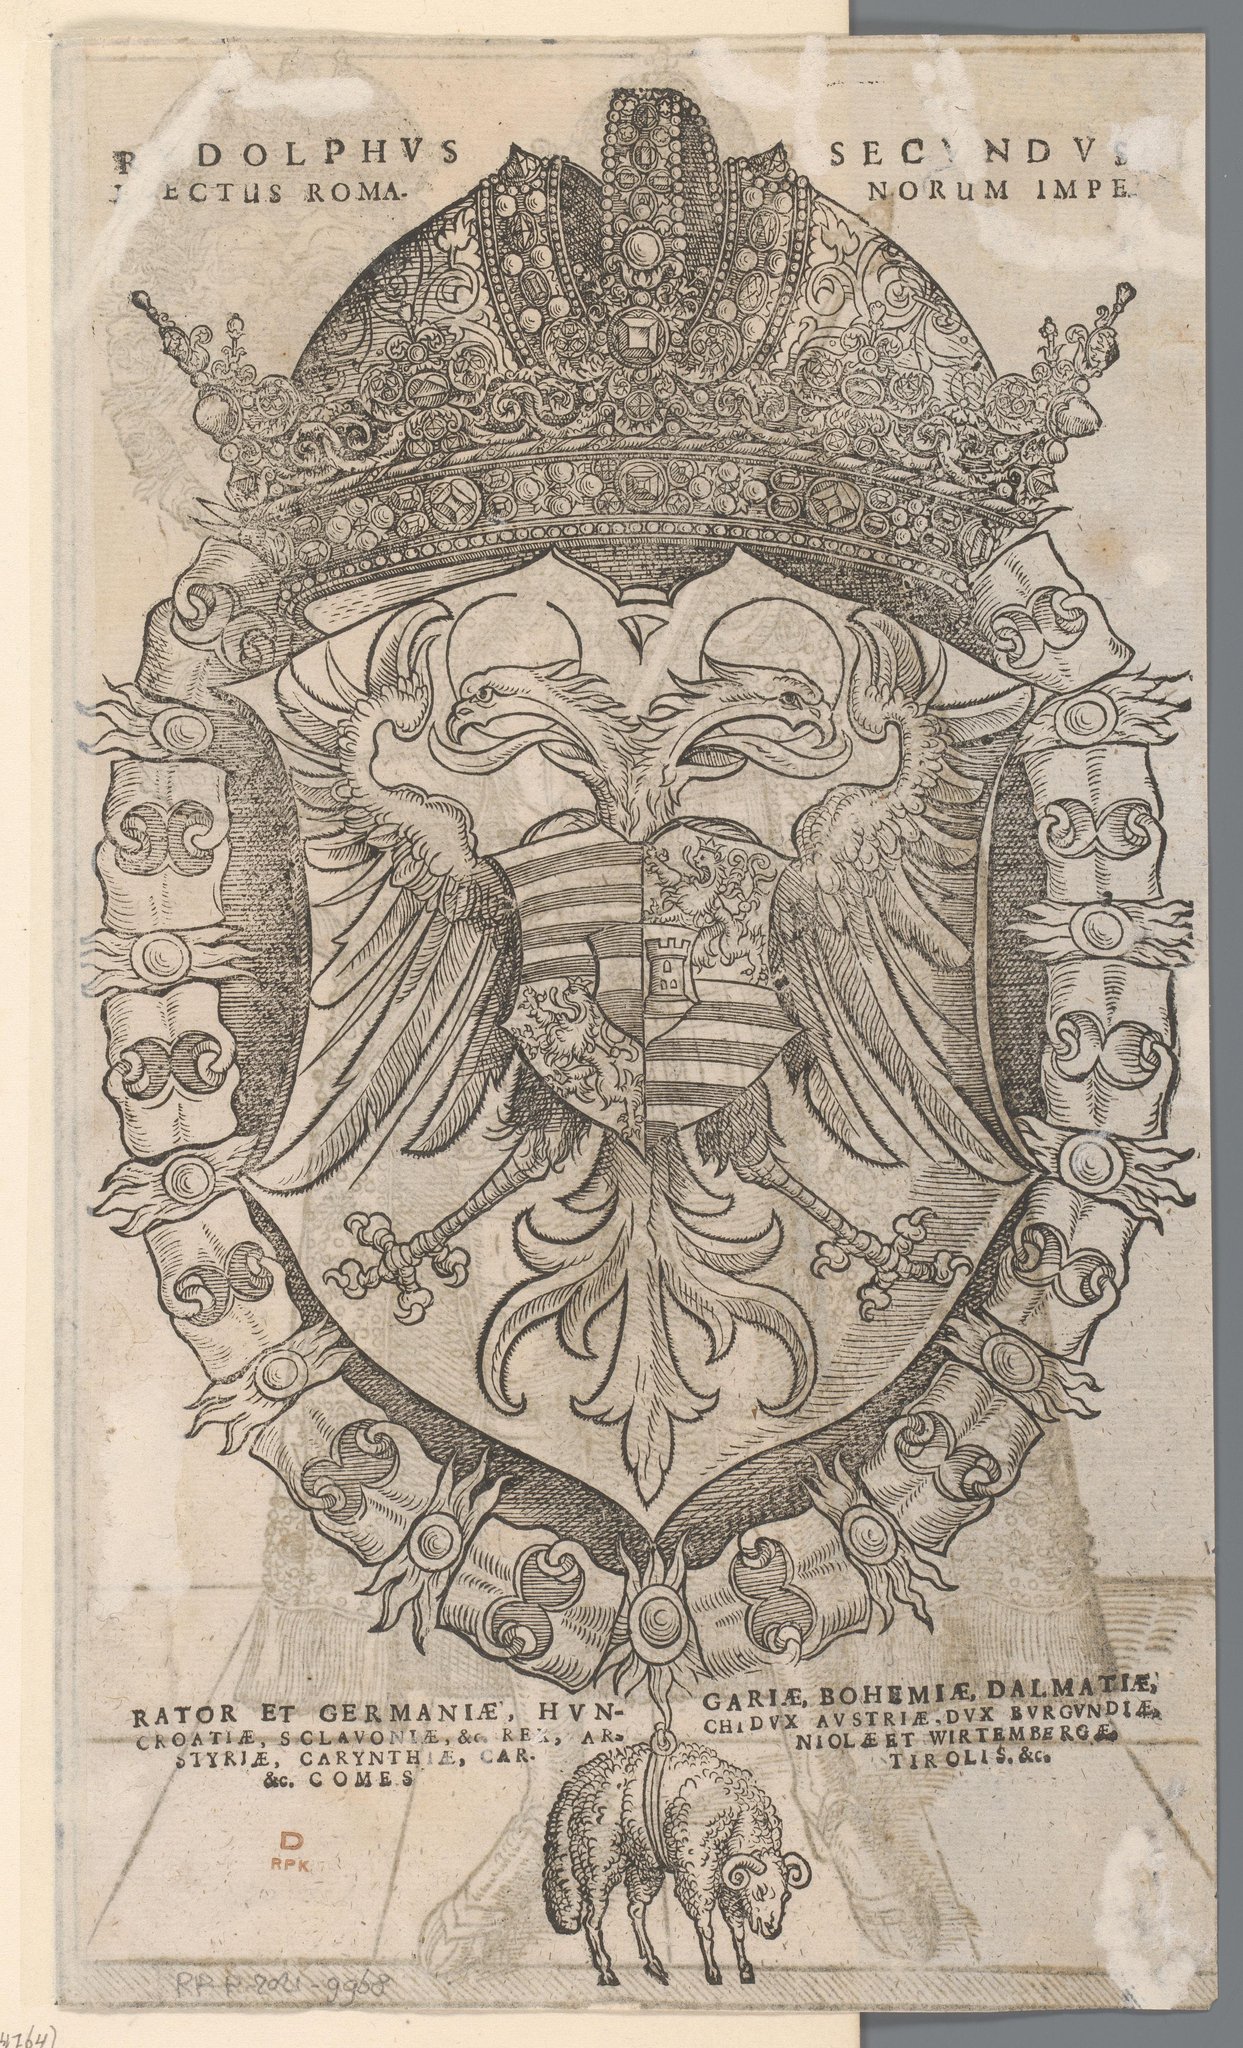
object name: print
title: Wapenschild van Rudolf II van Habsburg, Duits keizer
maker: Anonymous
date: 1576-1649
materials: paper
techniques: woodcut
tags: vienna, rudolf ii van habsburg (duits keizer), knighthood order of the golden fleece, armorial bearing, heraldry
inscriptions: collector's mark: Lugt 789a